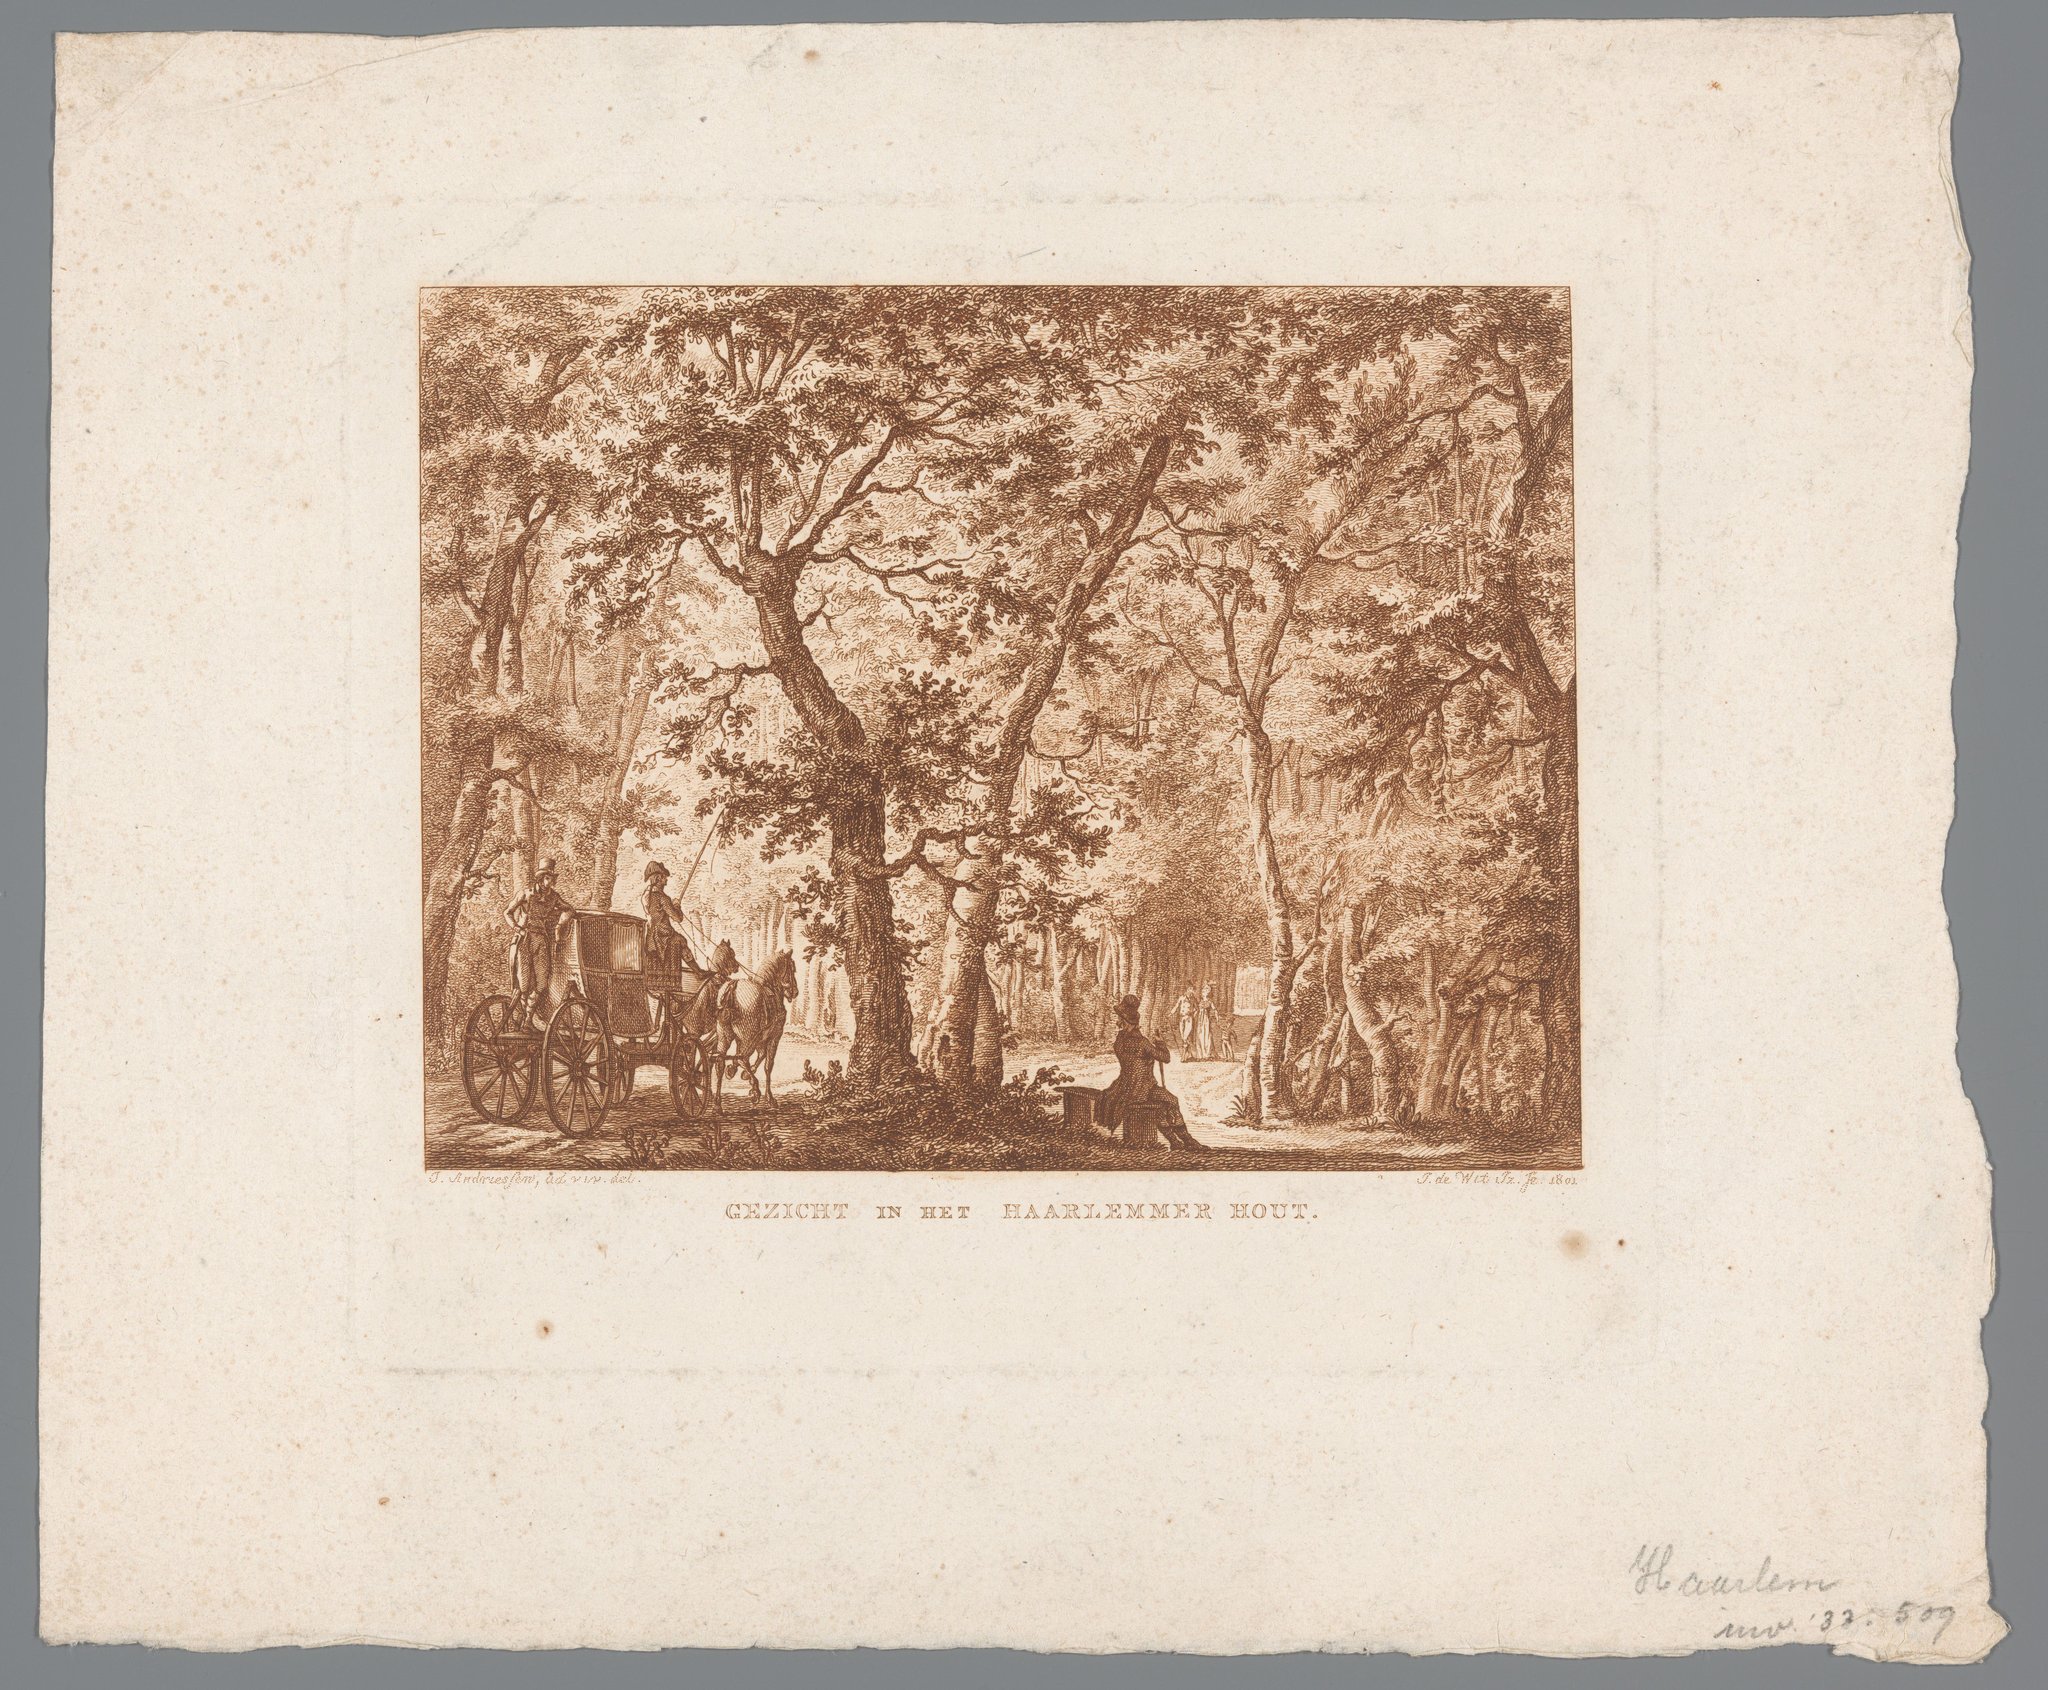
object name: print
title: Koets en wandelaars in de Haarlemmerhout in Haarlem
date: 1801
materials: paper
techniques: etching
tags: bench, walking-stick, staff, four-wheeled vehicle drawn by two animals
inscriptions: date